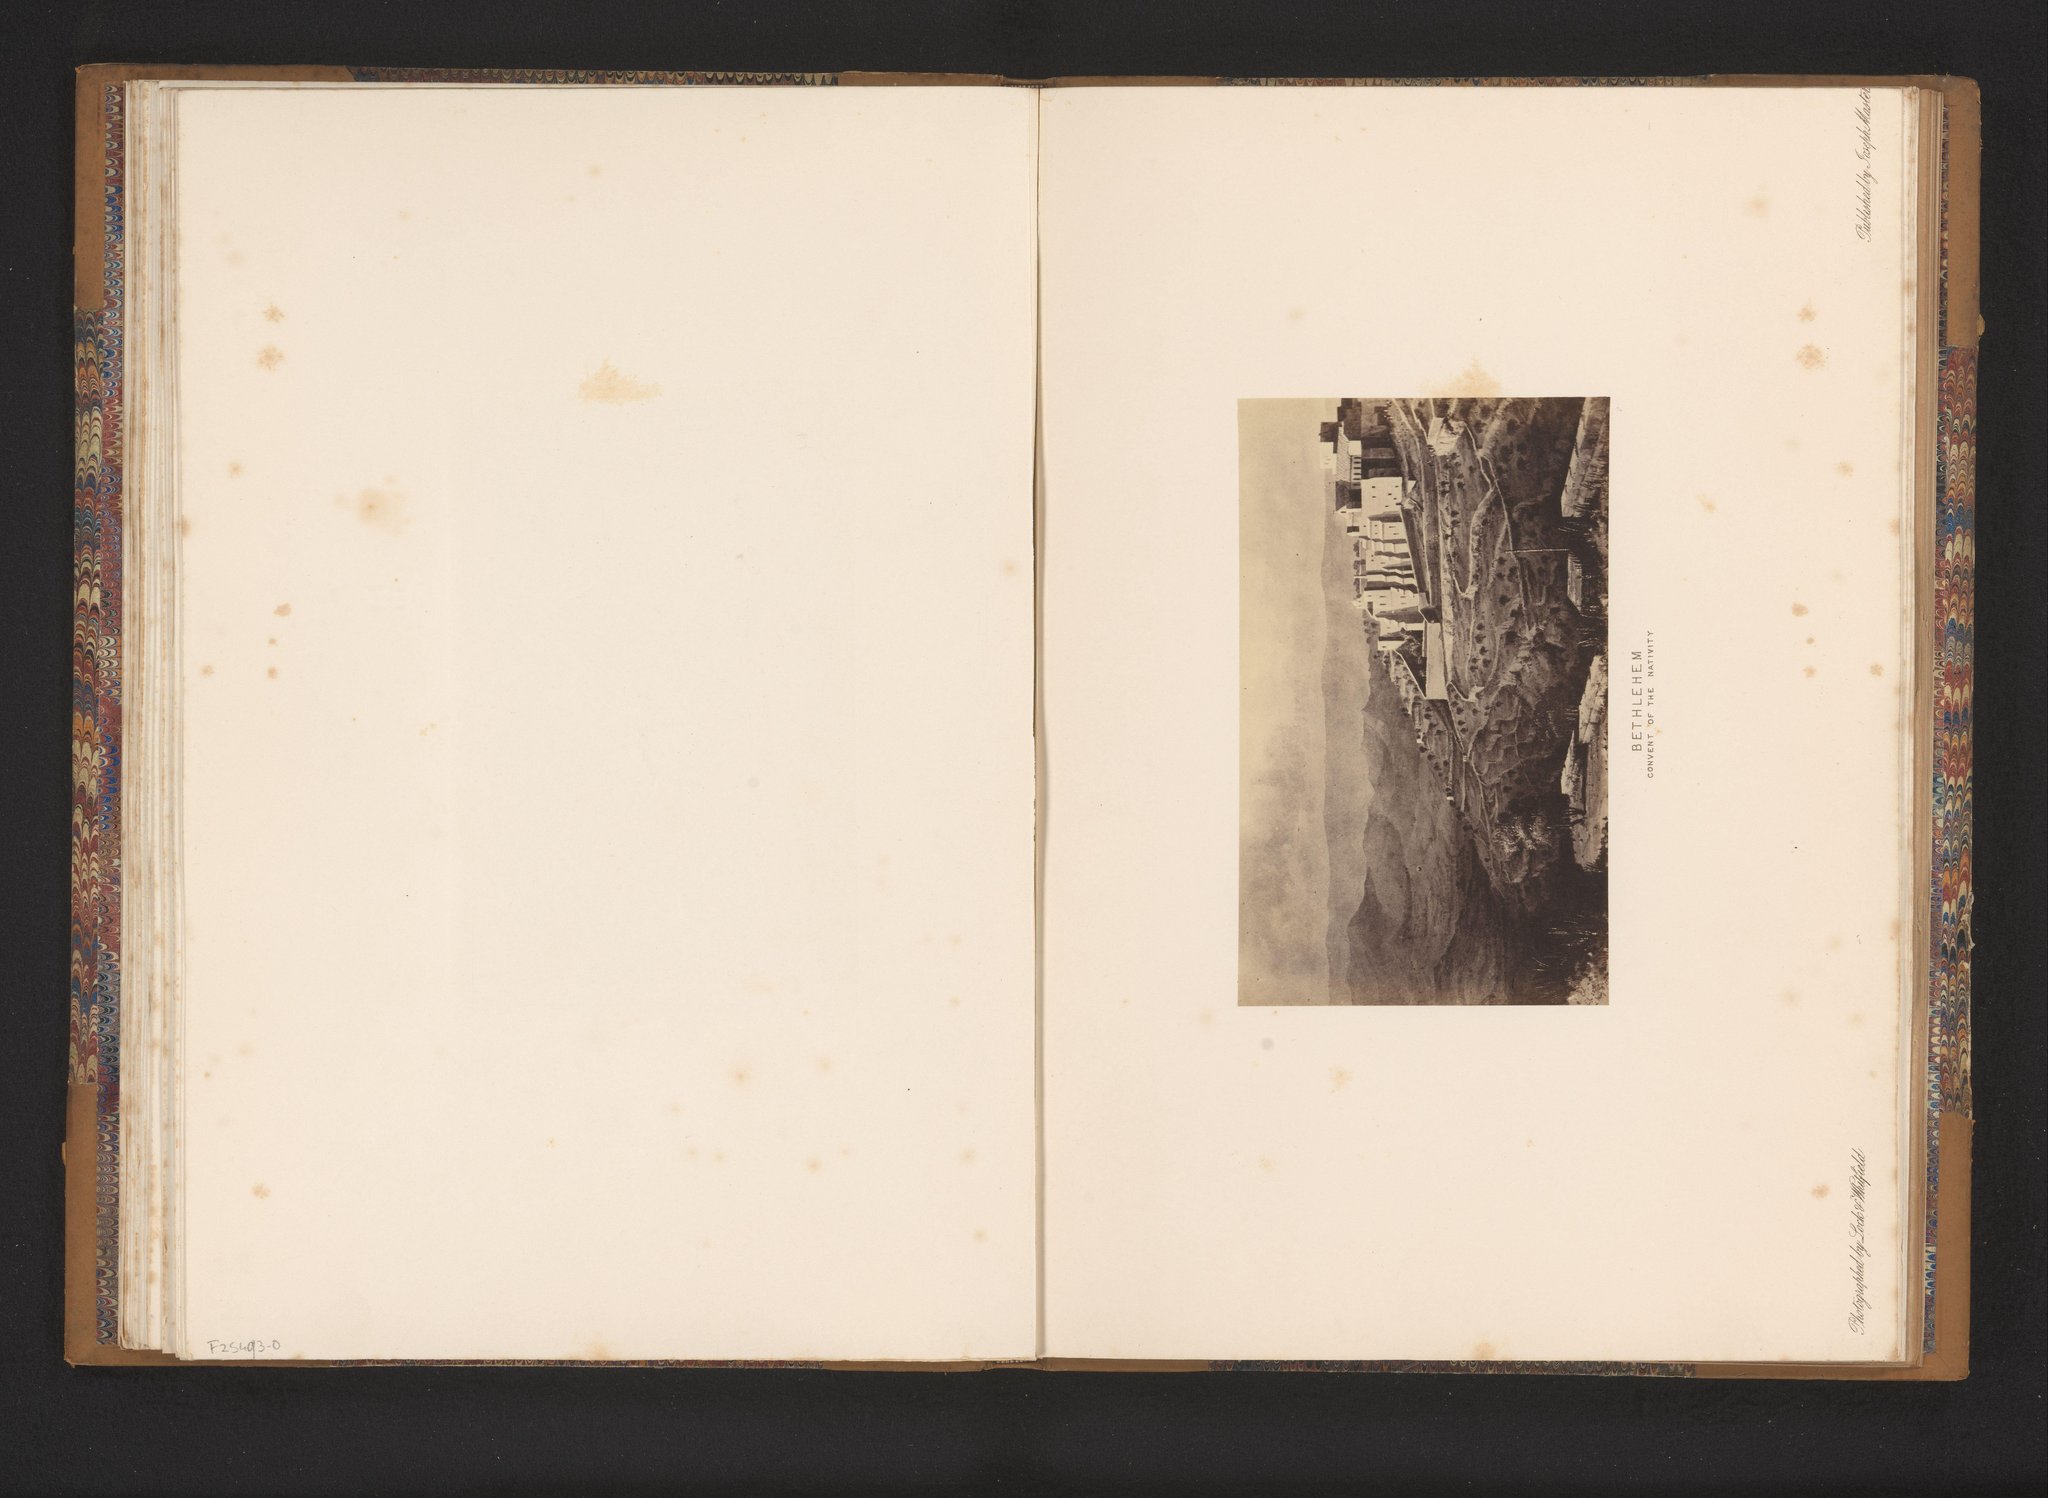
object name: page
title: Bethlehem, Convent of the Nativity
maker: conway mordaunt shipley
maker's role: draughtsman, painter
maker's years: 1824-1888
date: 1855-1865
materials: paper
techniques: albumen print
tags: abbey, monastery, convent ~ roman catholic church, church (exterior)